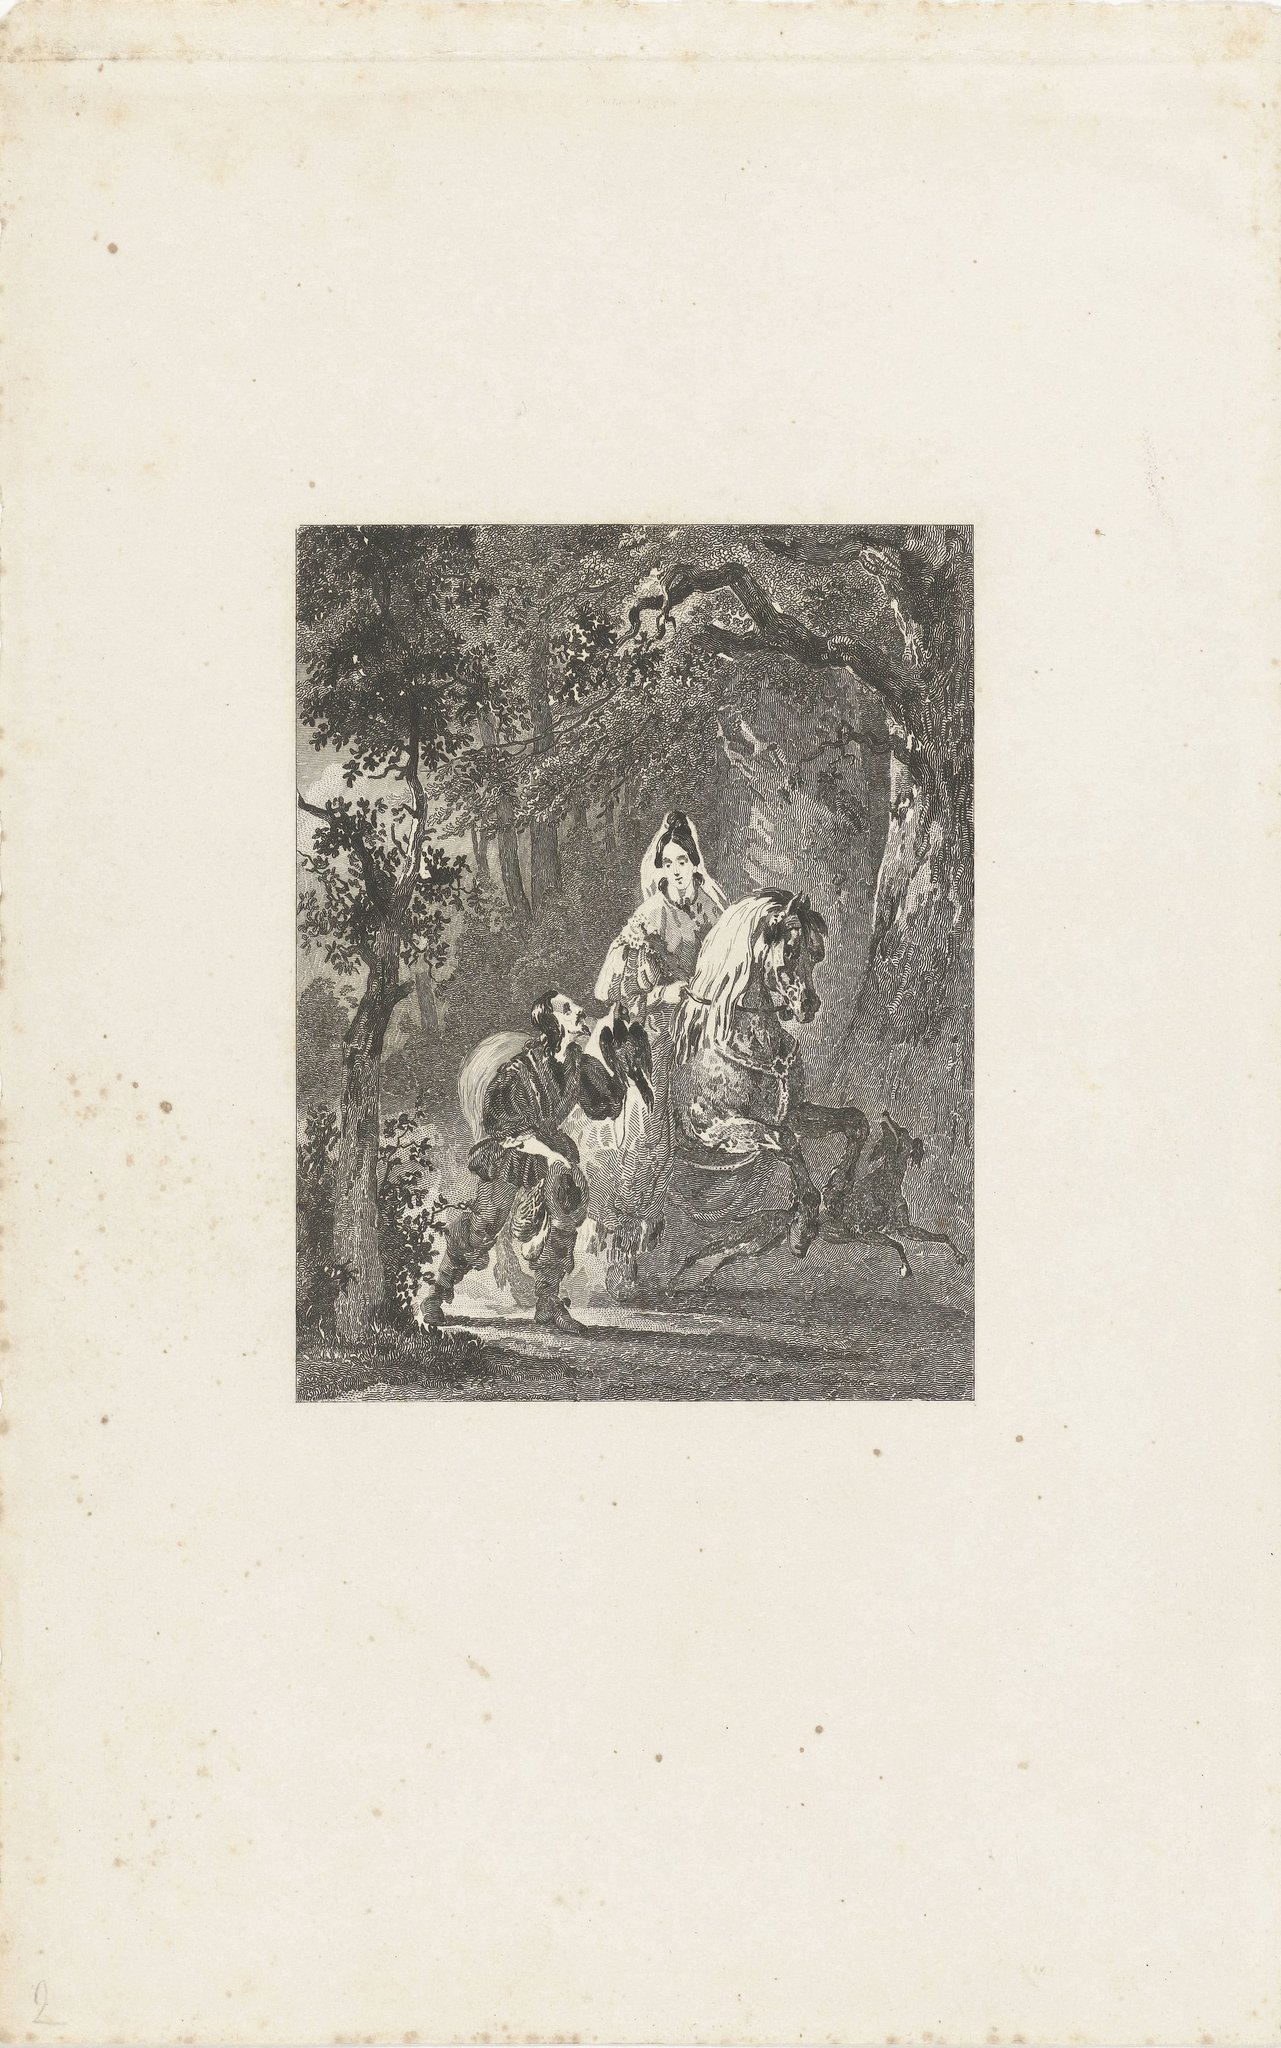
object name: book illustration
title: Een valkenier toont een dame te paard zijn vogel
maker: henricus wilhelmus couwenberg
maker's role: draughtsman, print maker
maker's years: 1814-1845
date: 1830-1845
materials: paper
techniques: engraving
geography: amsterdam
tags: fowling, fowler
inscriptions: collector's mark: Lugt 2228